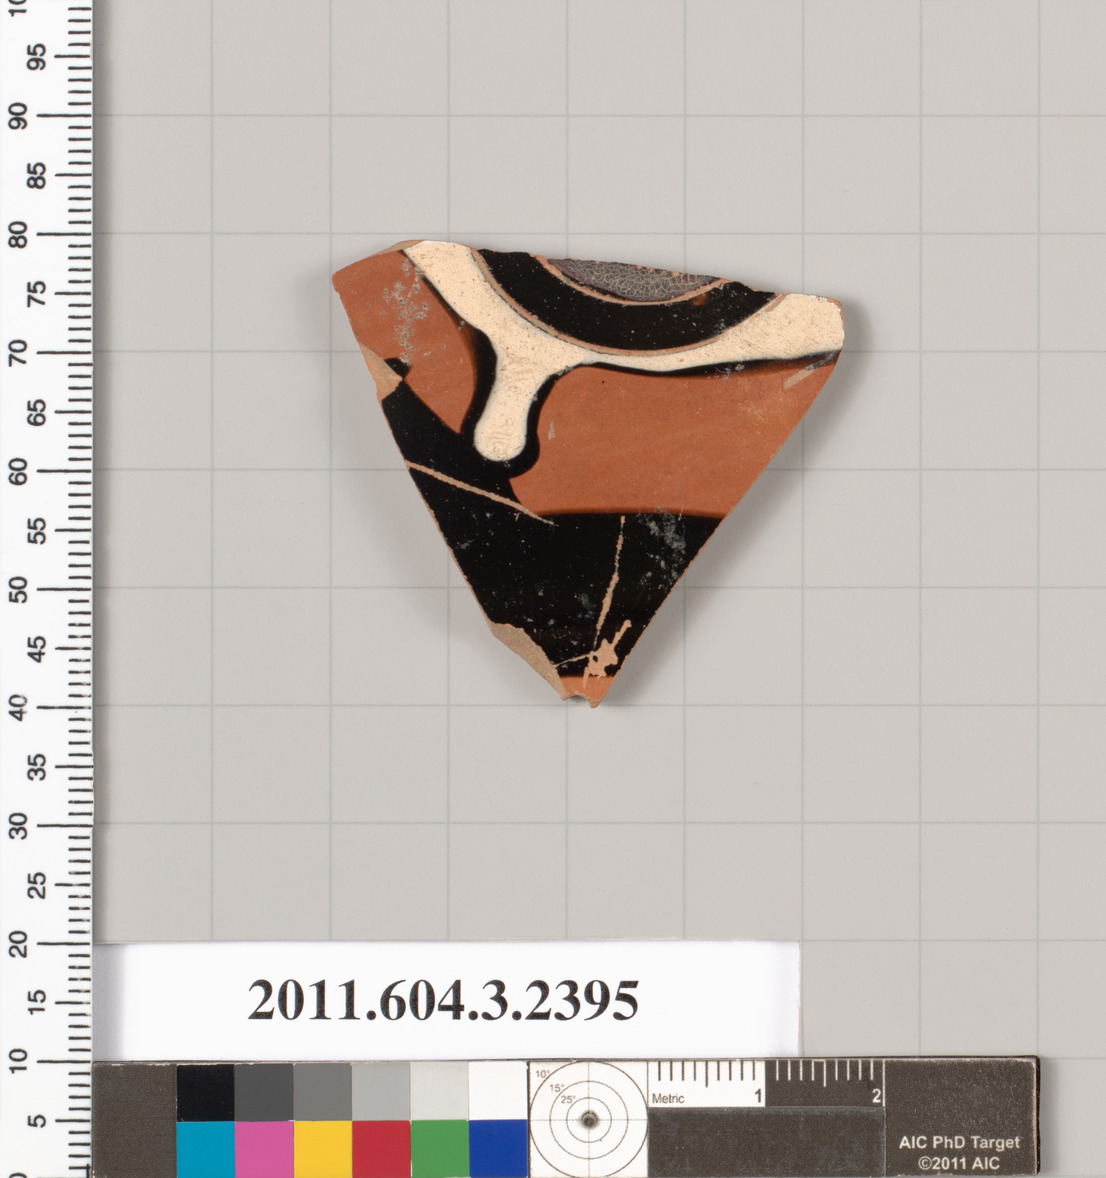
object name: kylix fragment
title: Terracotta fragment of a kylix: eye-cup (drinking cup)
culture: greek, attic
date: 530-510 BCE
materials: terracotta